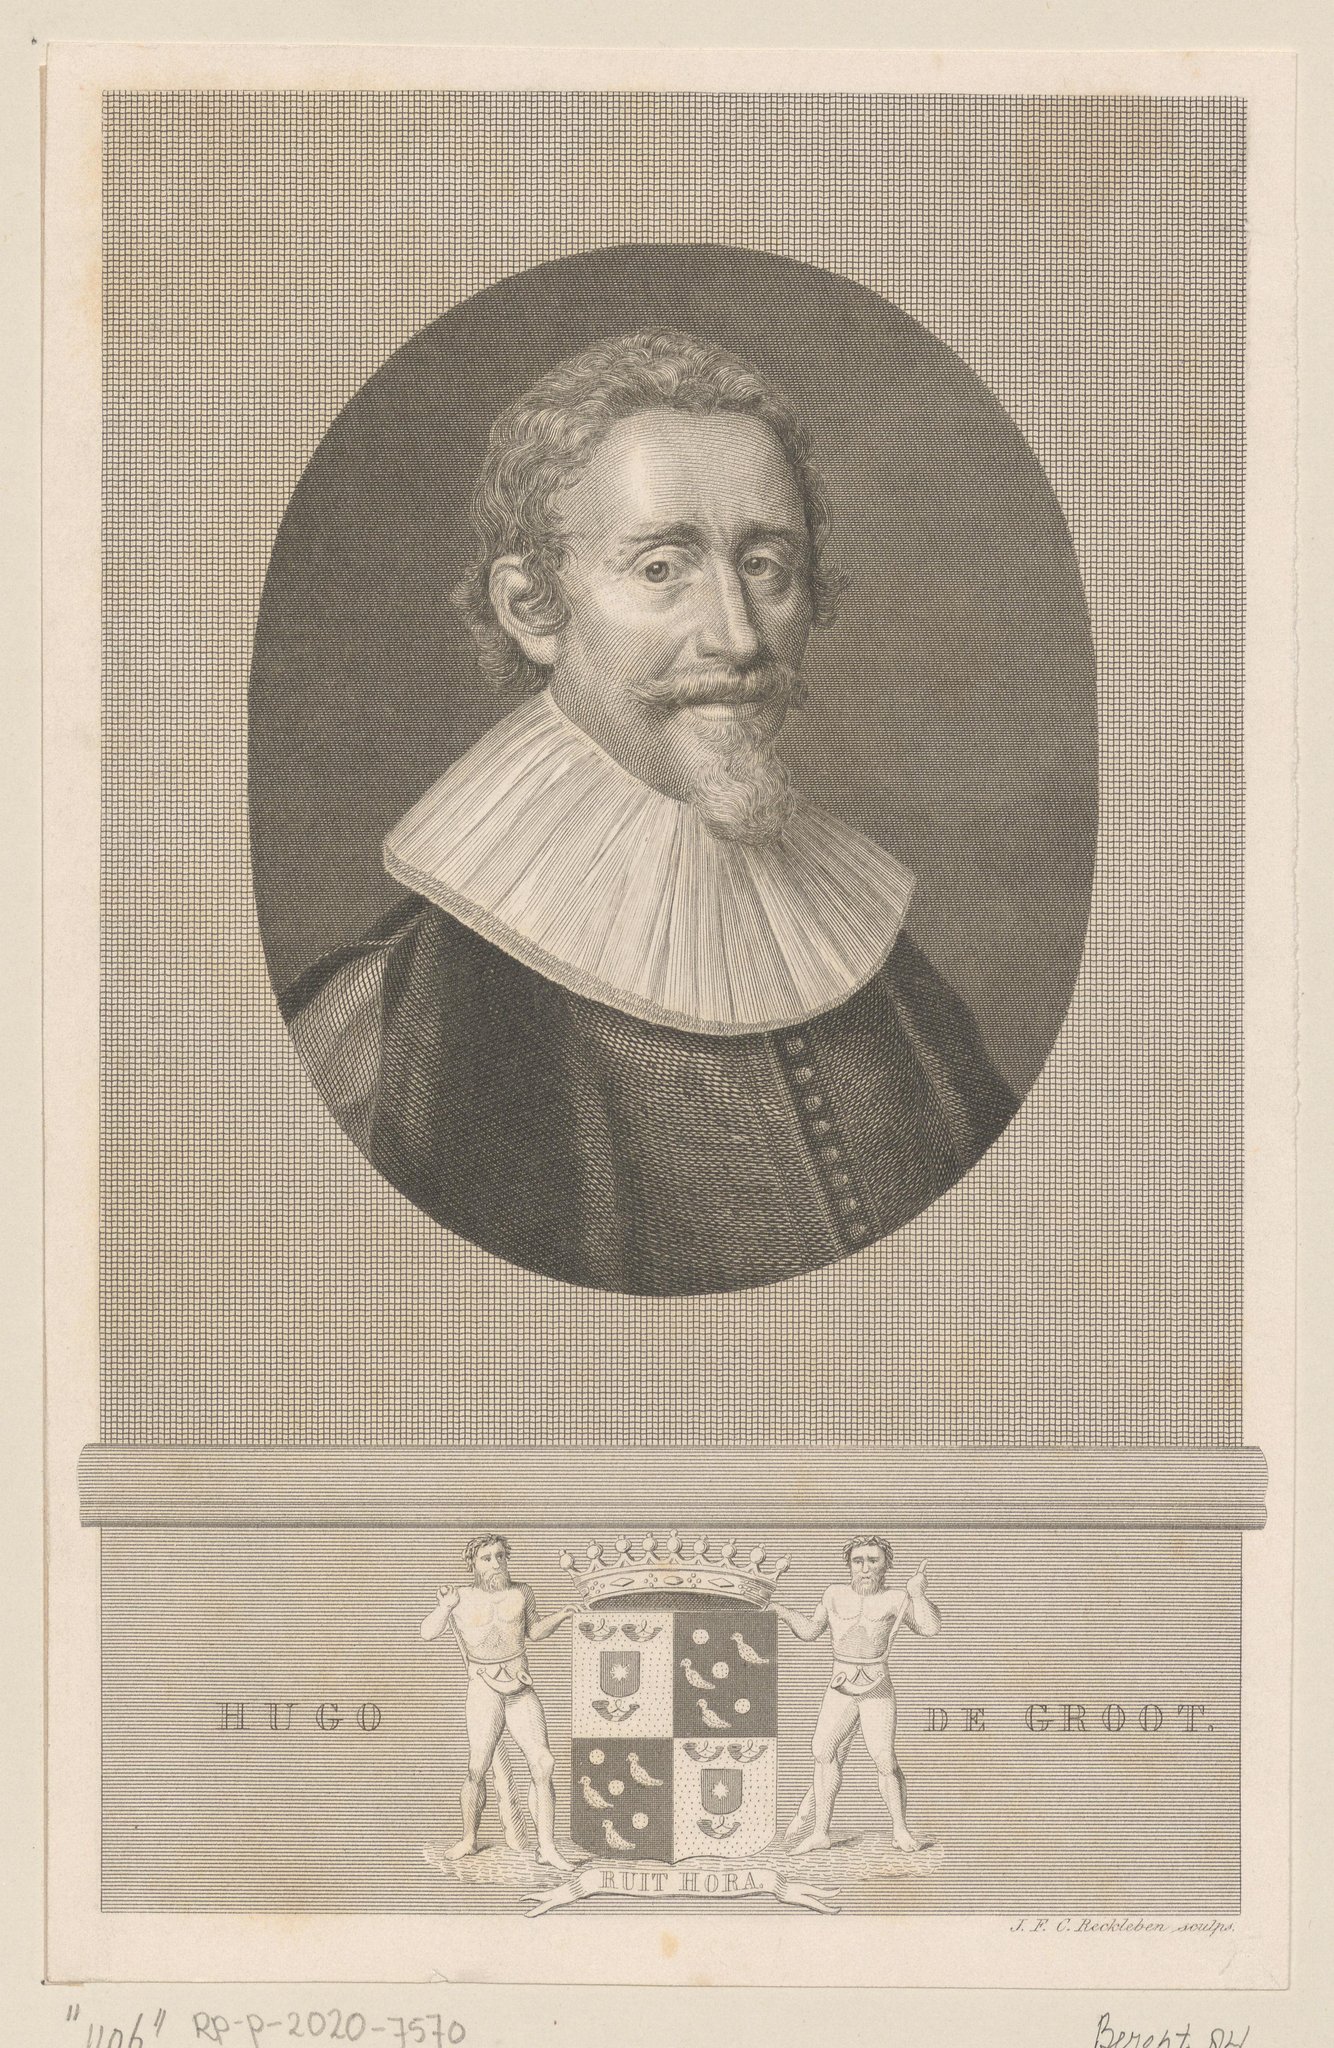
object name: print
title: Portret van Hugo de Groot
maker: jan frederik christiaan reckleben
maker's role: print maker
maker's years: 1819-1879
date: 1829-1879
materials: paper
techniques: engraving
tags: delft, hugo de groot, historical persons, portrait of a writer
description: Prent mogelijk uit: Arend, Johannes Pieter. Algemeene geschiedenis des vaderlands van de vroegste tijden tot op heden. Amsterdam: J. F. Schleijer, [1840-1884].